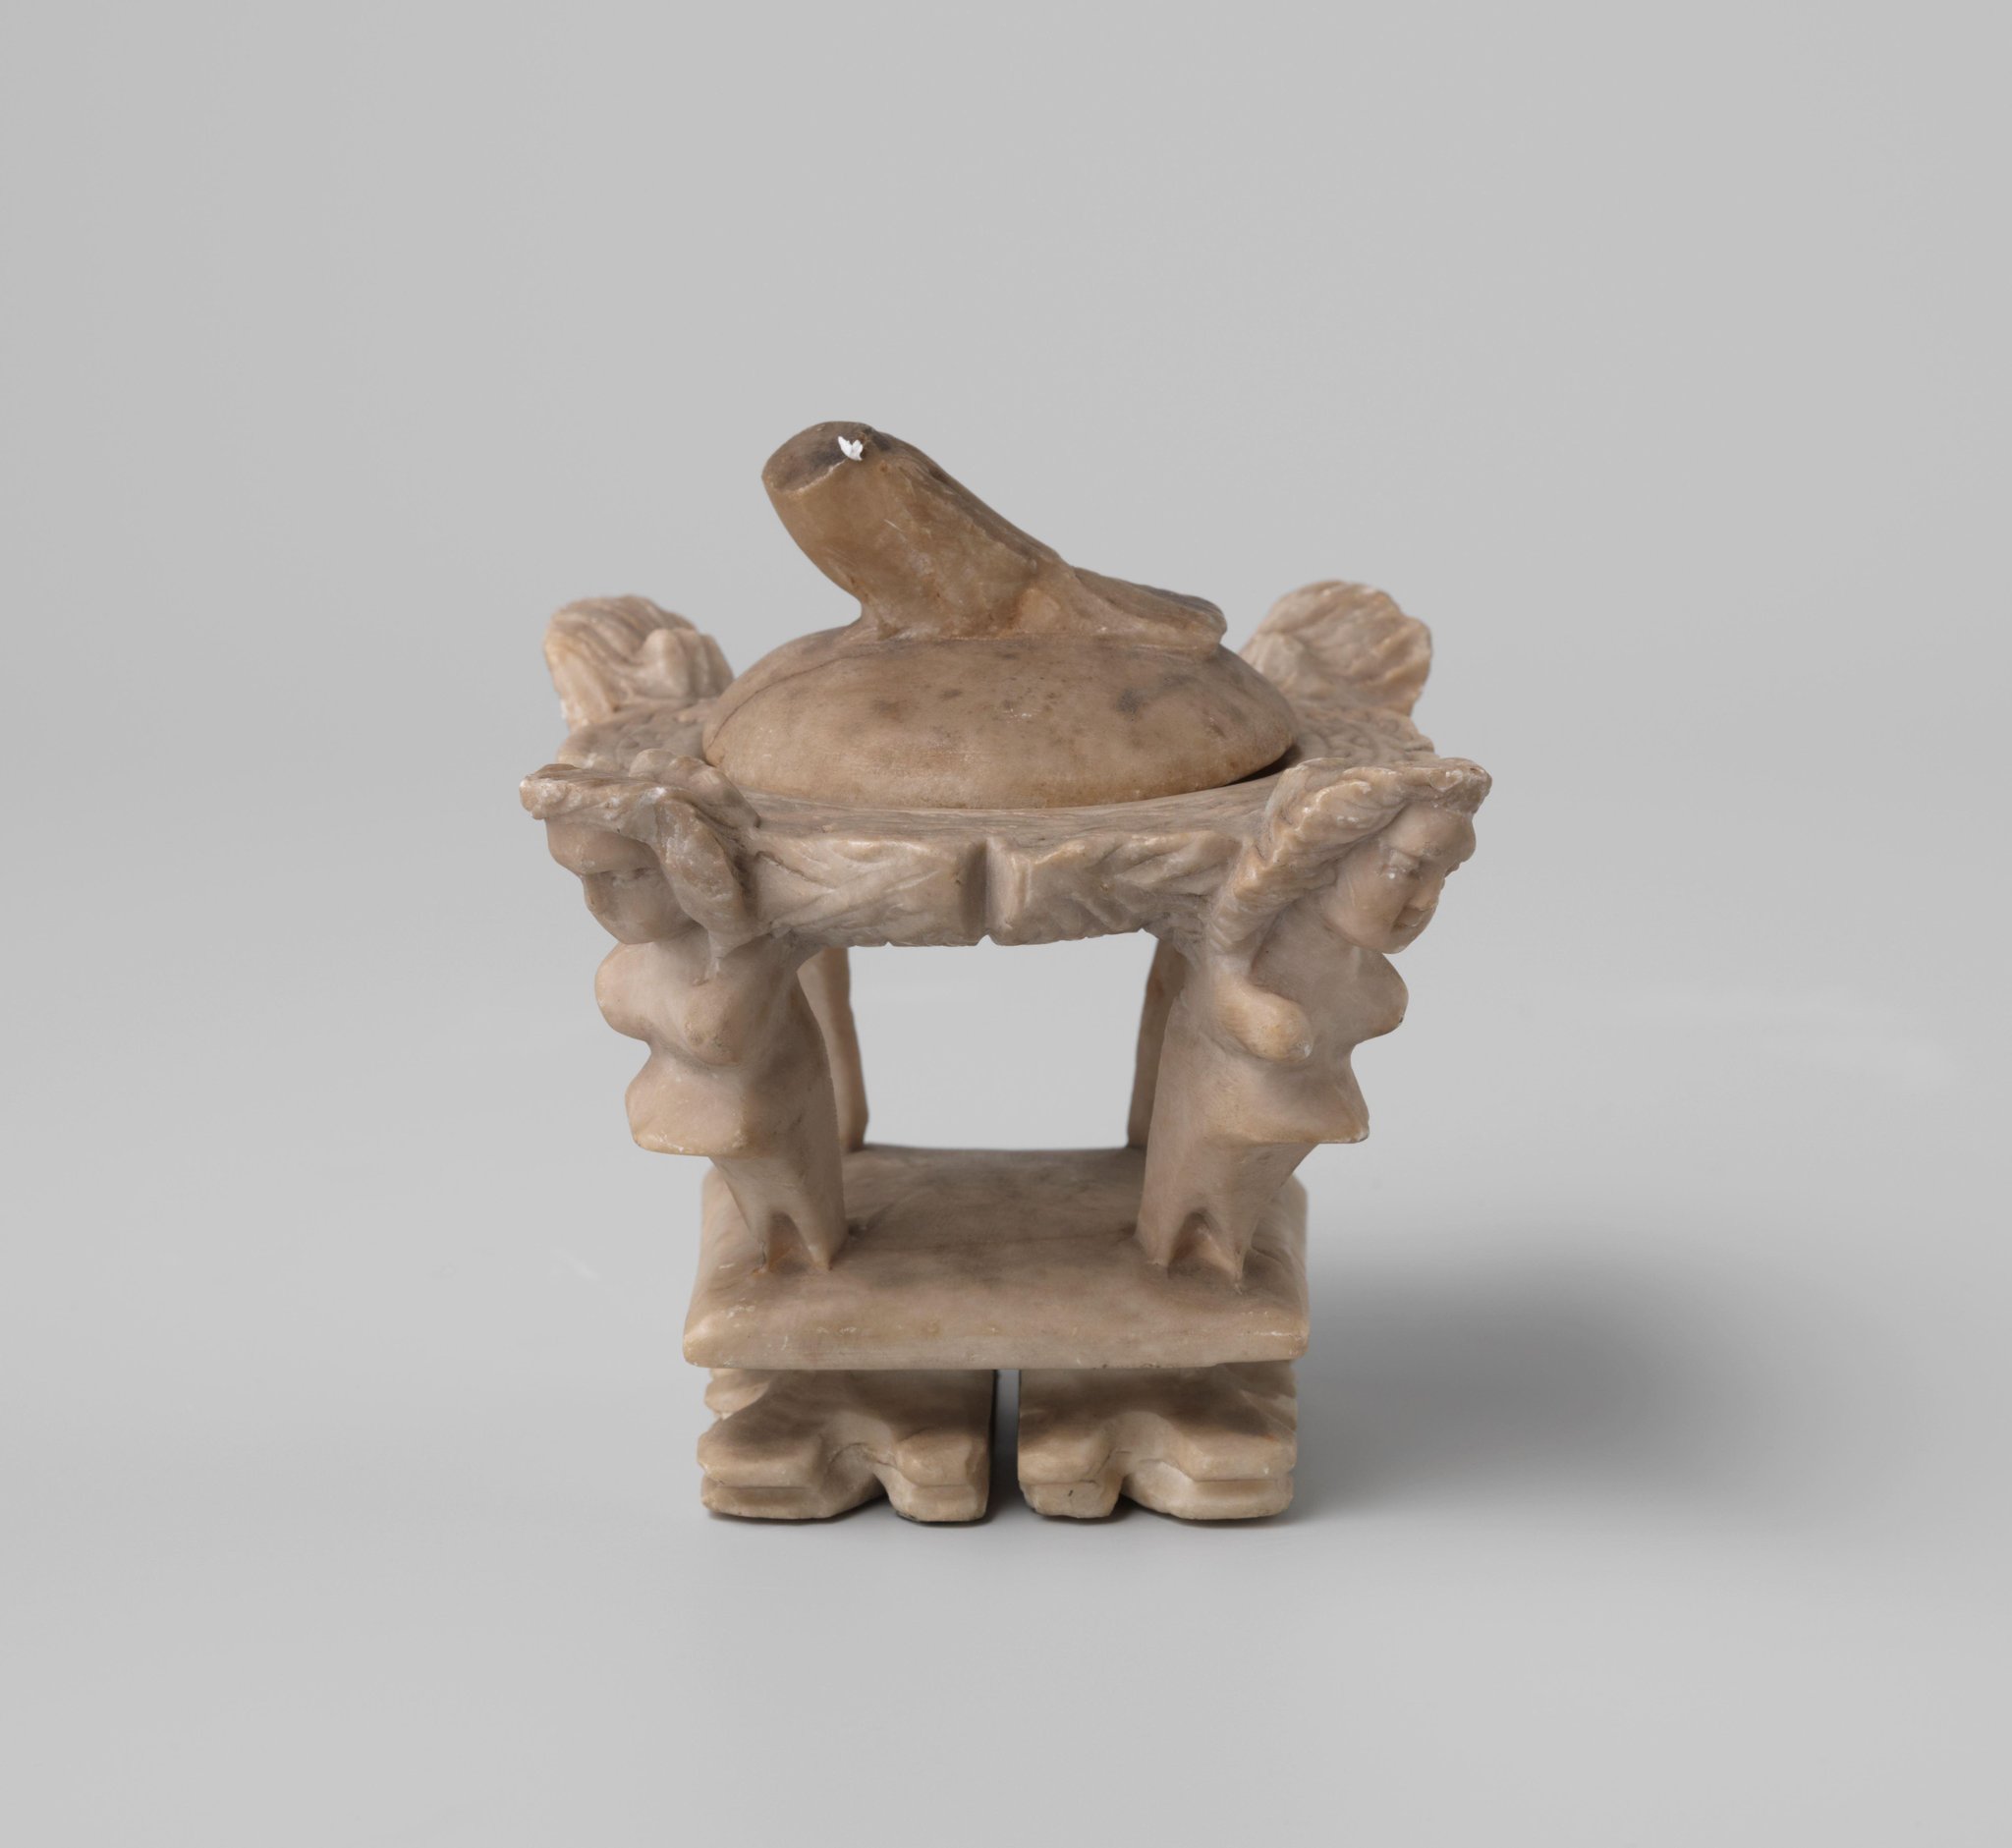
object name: coupe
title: Marmeren coupe met deksel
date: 1640-1660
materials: marble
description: Coupe van wit marmer gedragen door vier vrouwelijke kariatiden. Op het deksel een vogel.